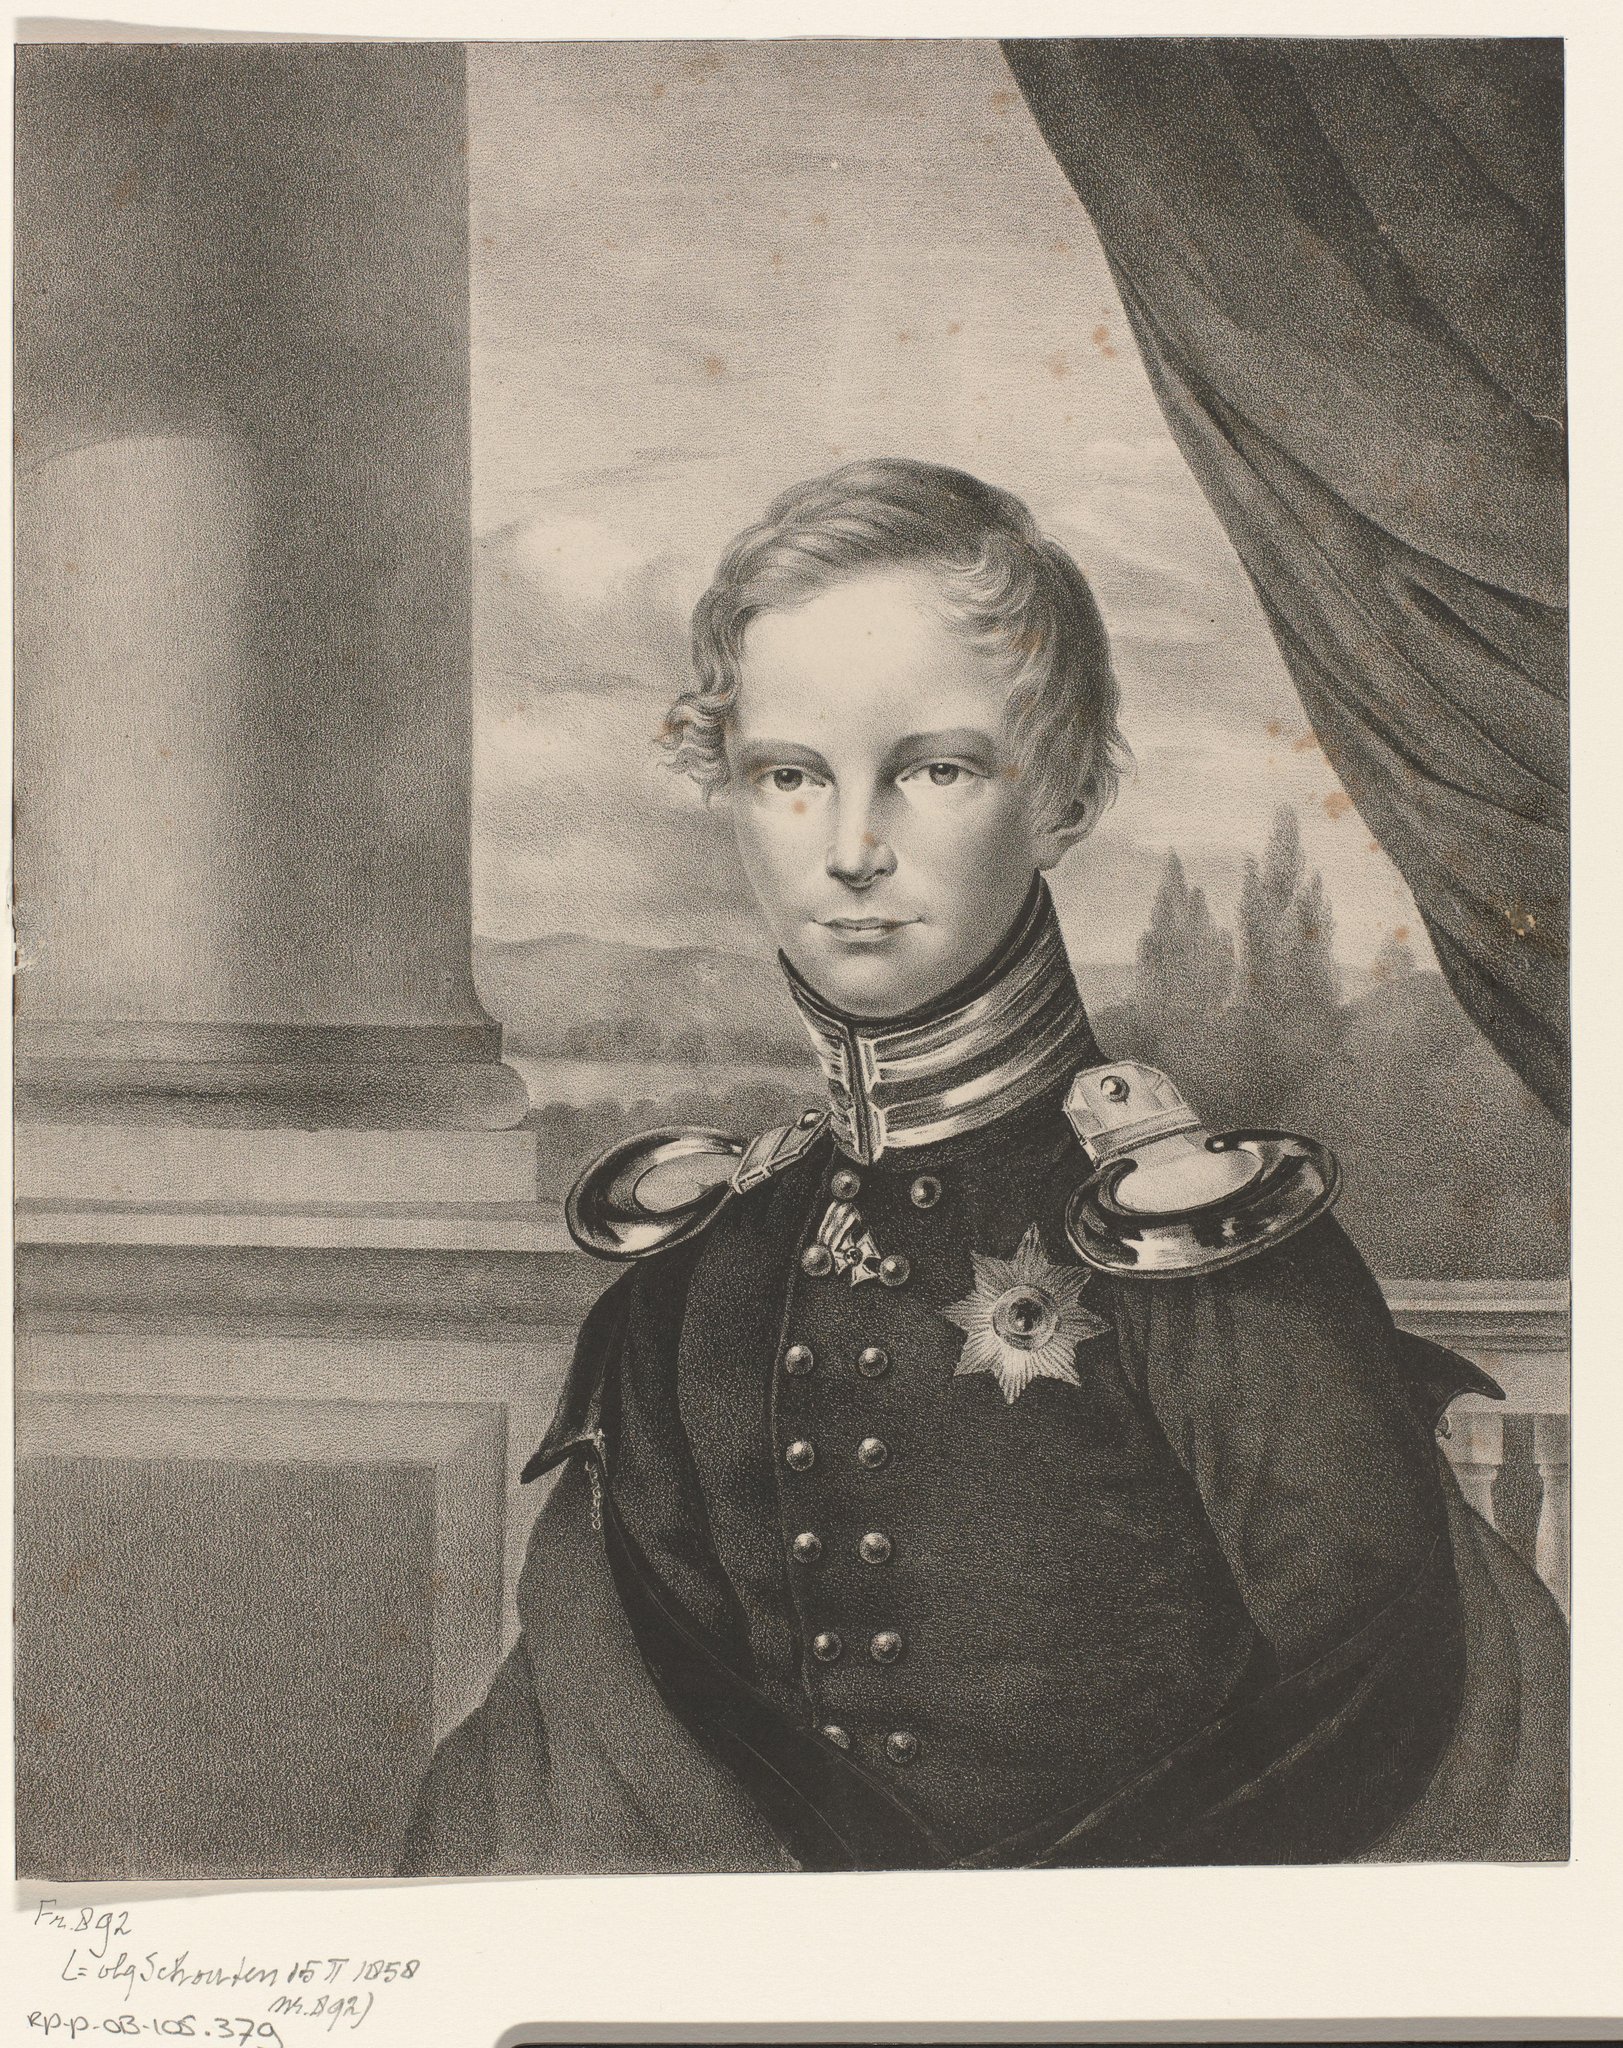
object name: print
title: Portret van Albert van Pruisen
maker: Anonymous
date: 1820-1871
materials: paper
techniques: lithograph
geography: netherlands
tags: knighthood order (with name) - insignia of a knighthood order, e.g.: badge, chain (with name of order)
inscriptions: collector's mark: Lugt 963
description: Portret van Albert van Pruisen. Op de achtergrond een doorkijkje.